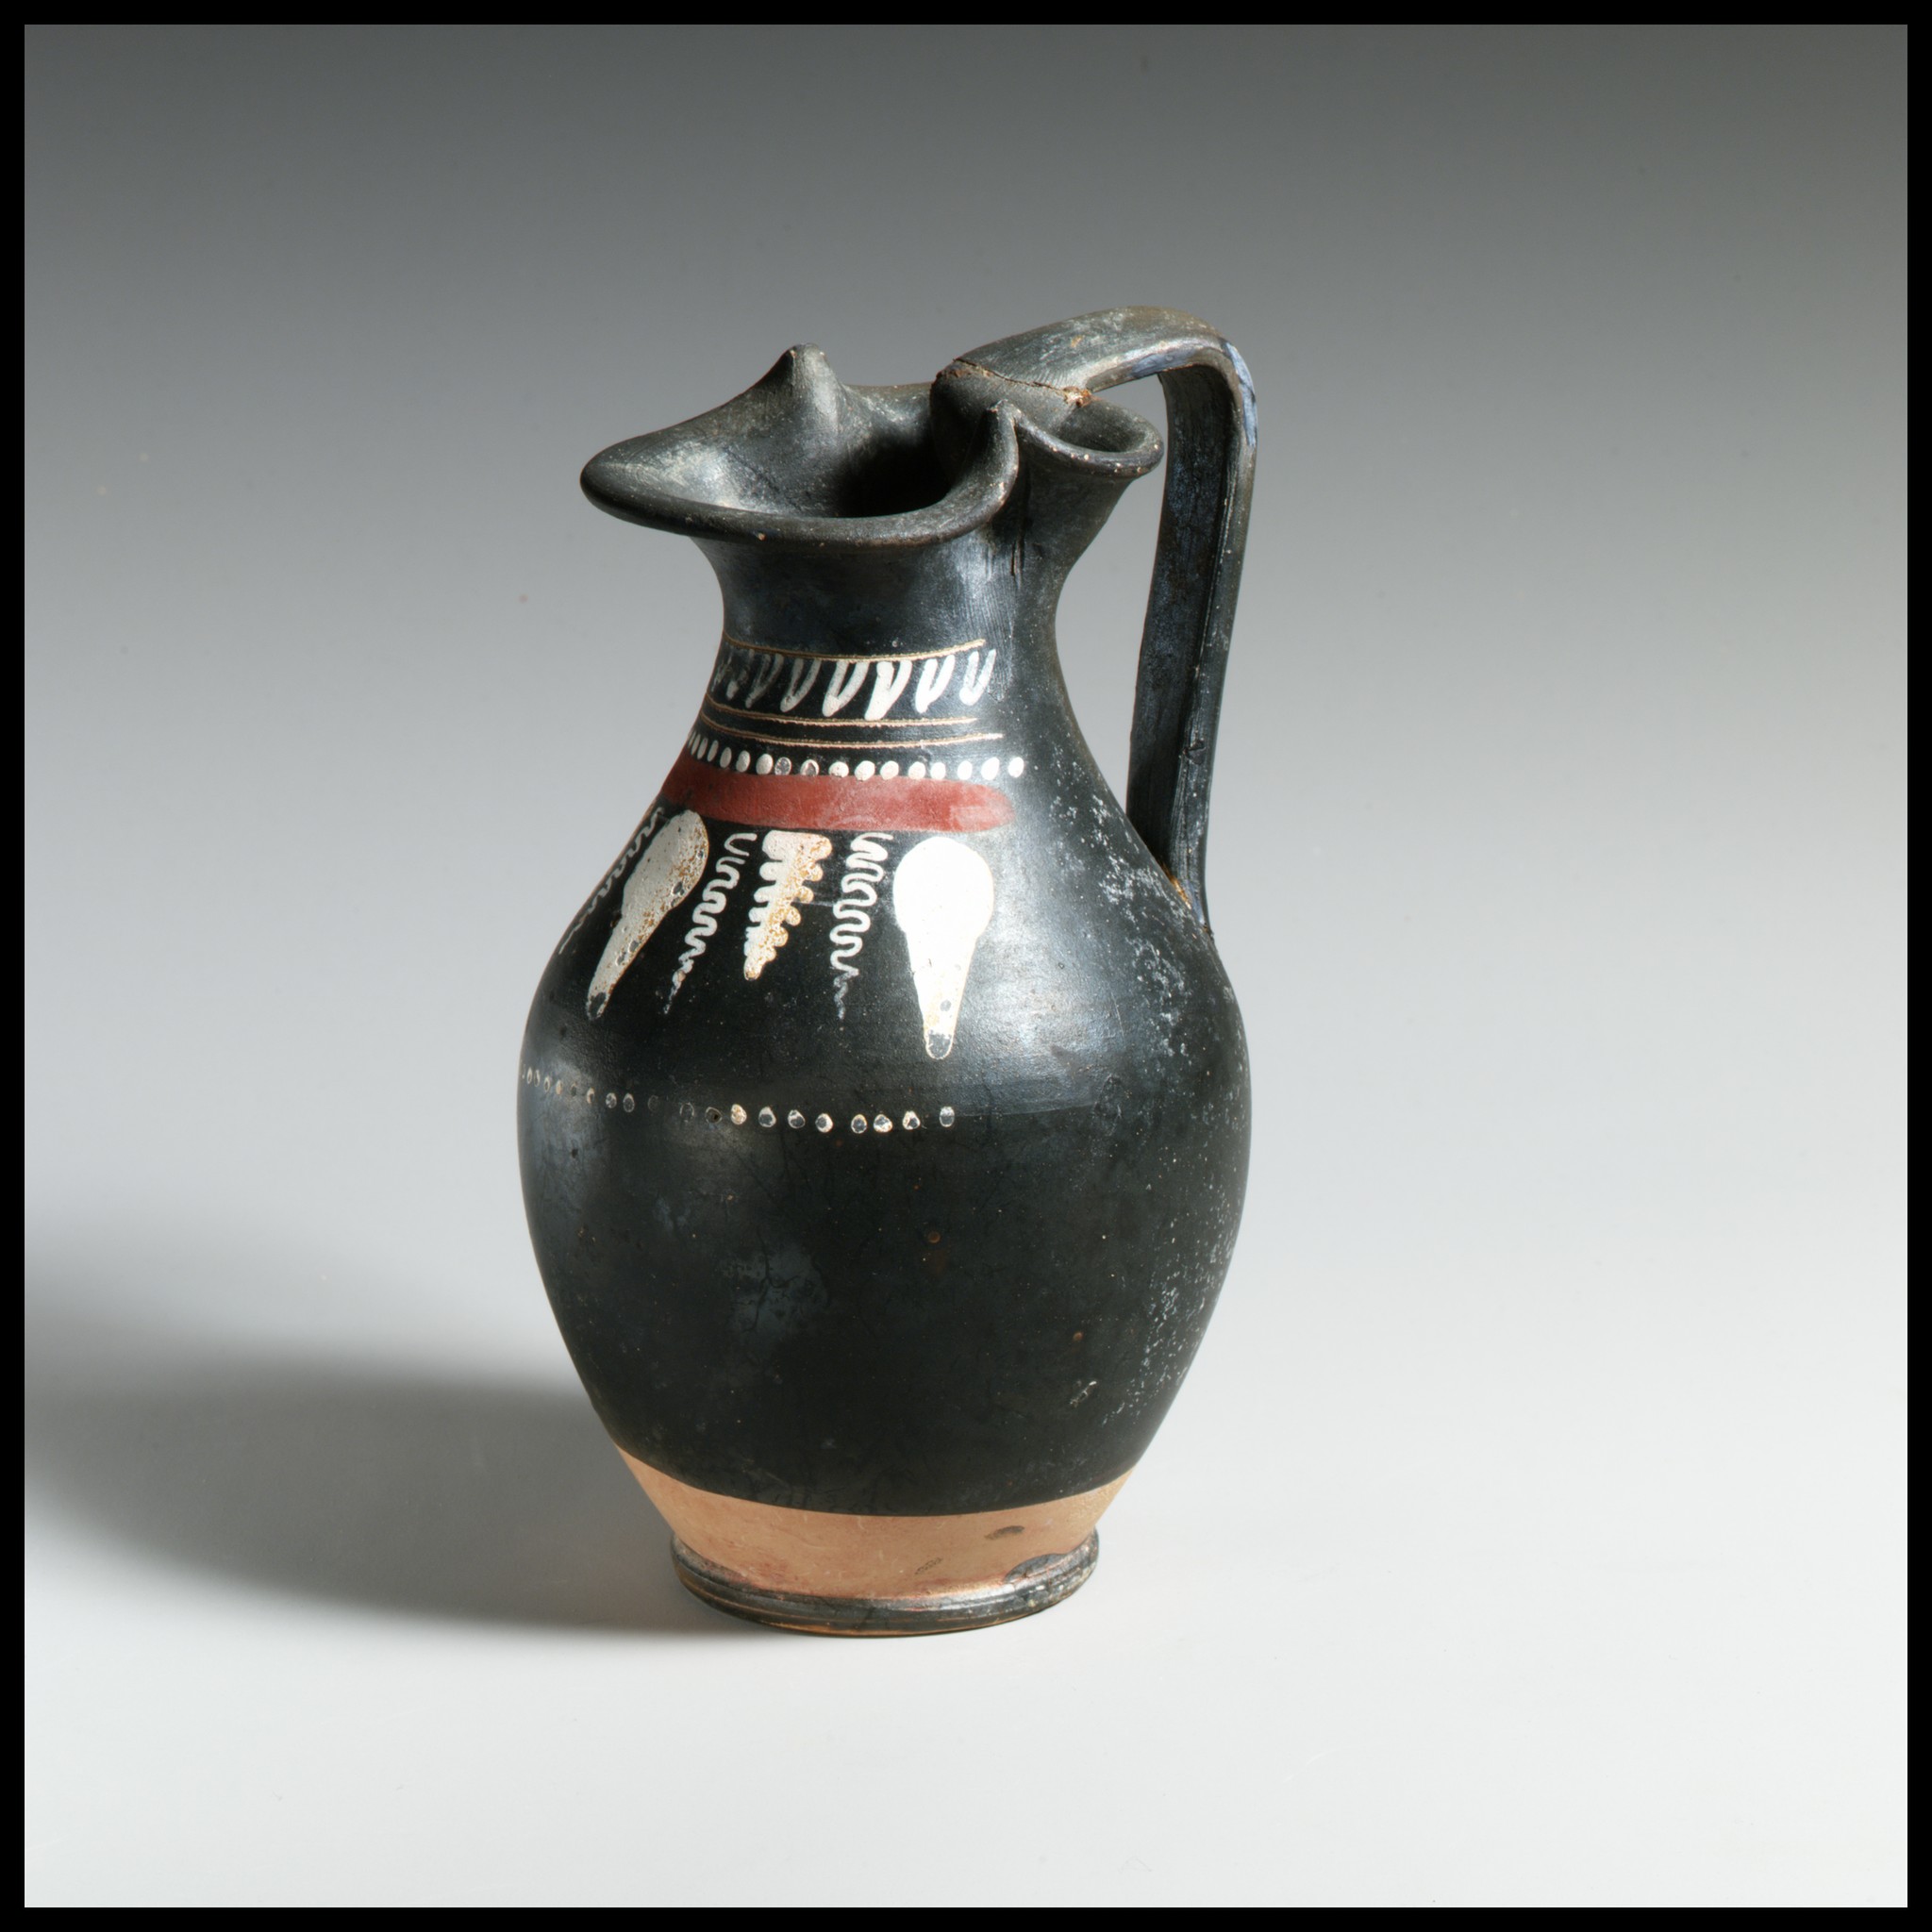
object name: oinochoe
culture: greek, south italian, apulian, canosan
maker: knudsen group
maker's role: artist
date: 350-300 BCE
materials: terracotta